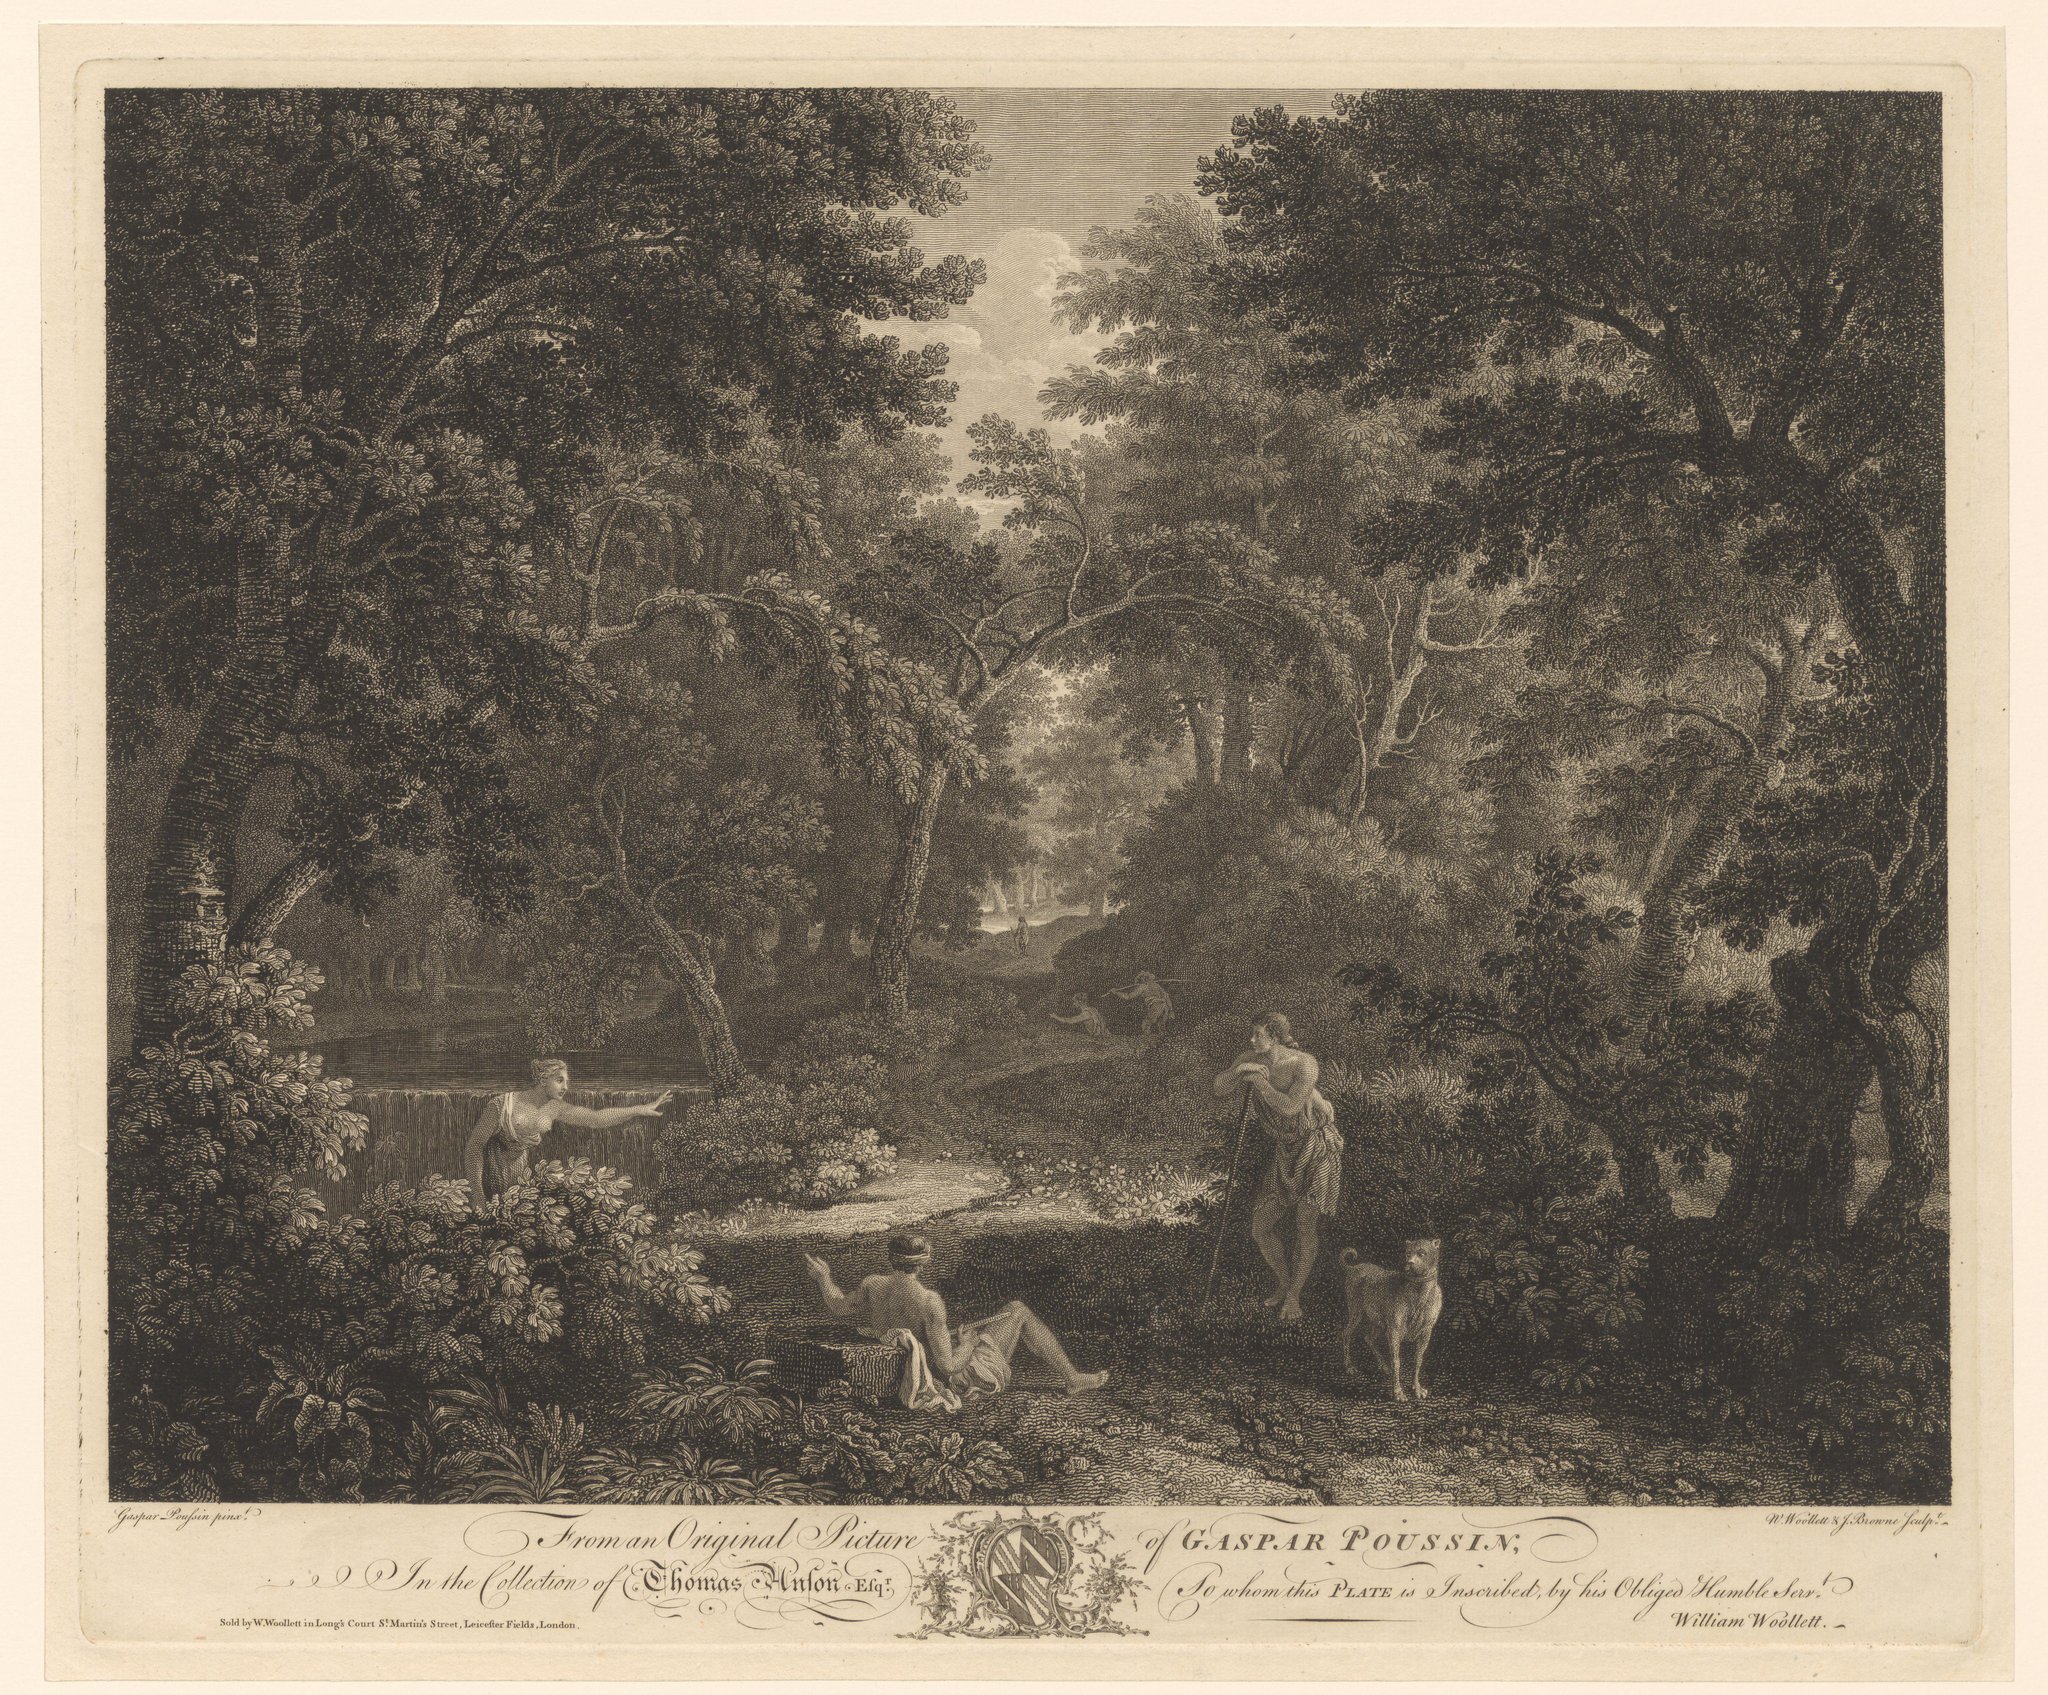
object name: print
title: Boslandschap met twee mannen en vrouw bij een waterval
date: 1763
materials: paper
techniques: etching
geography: london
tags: waterfall, forest, wood, dog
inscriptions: collector's mark: Lugt 12